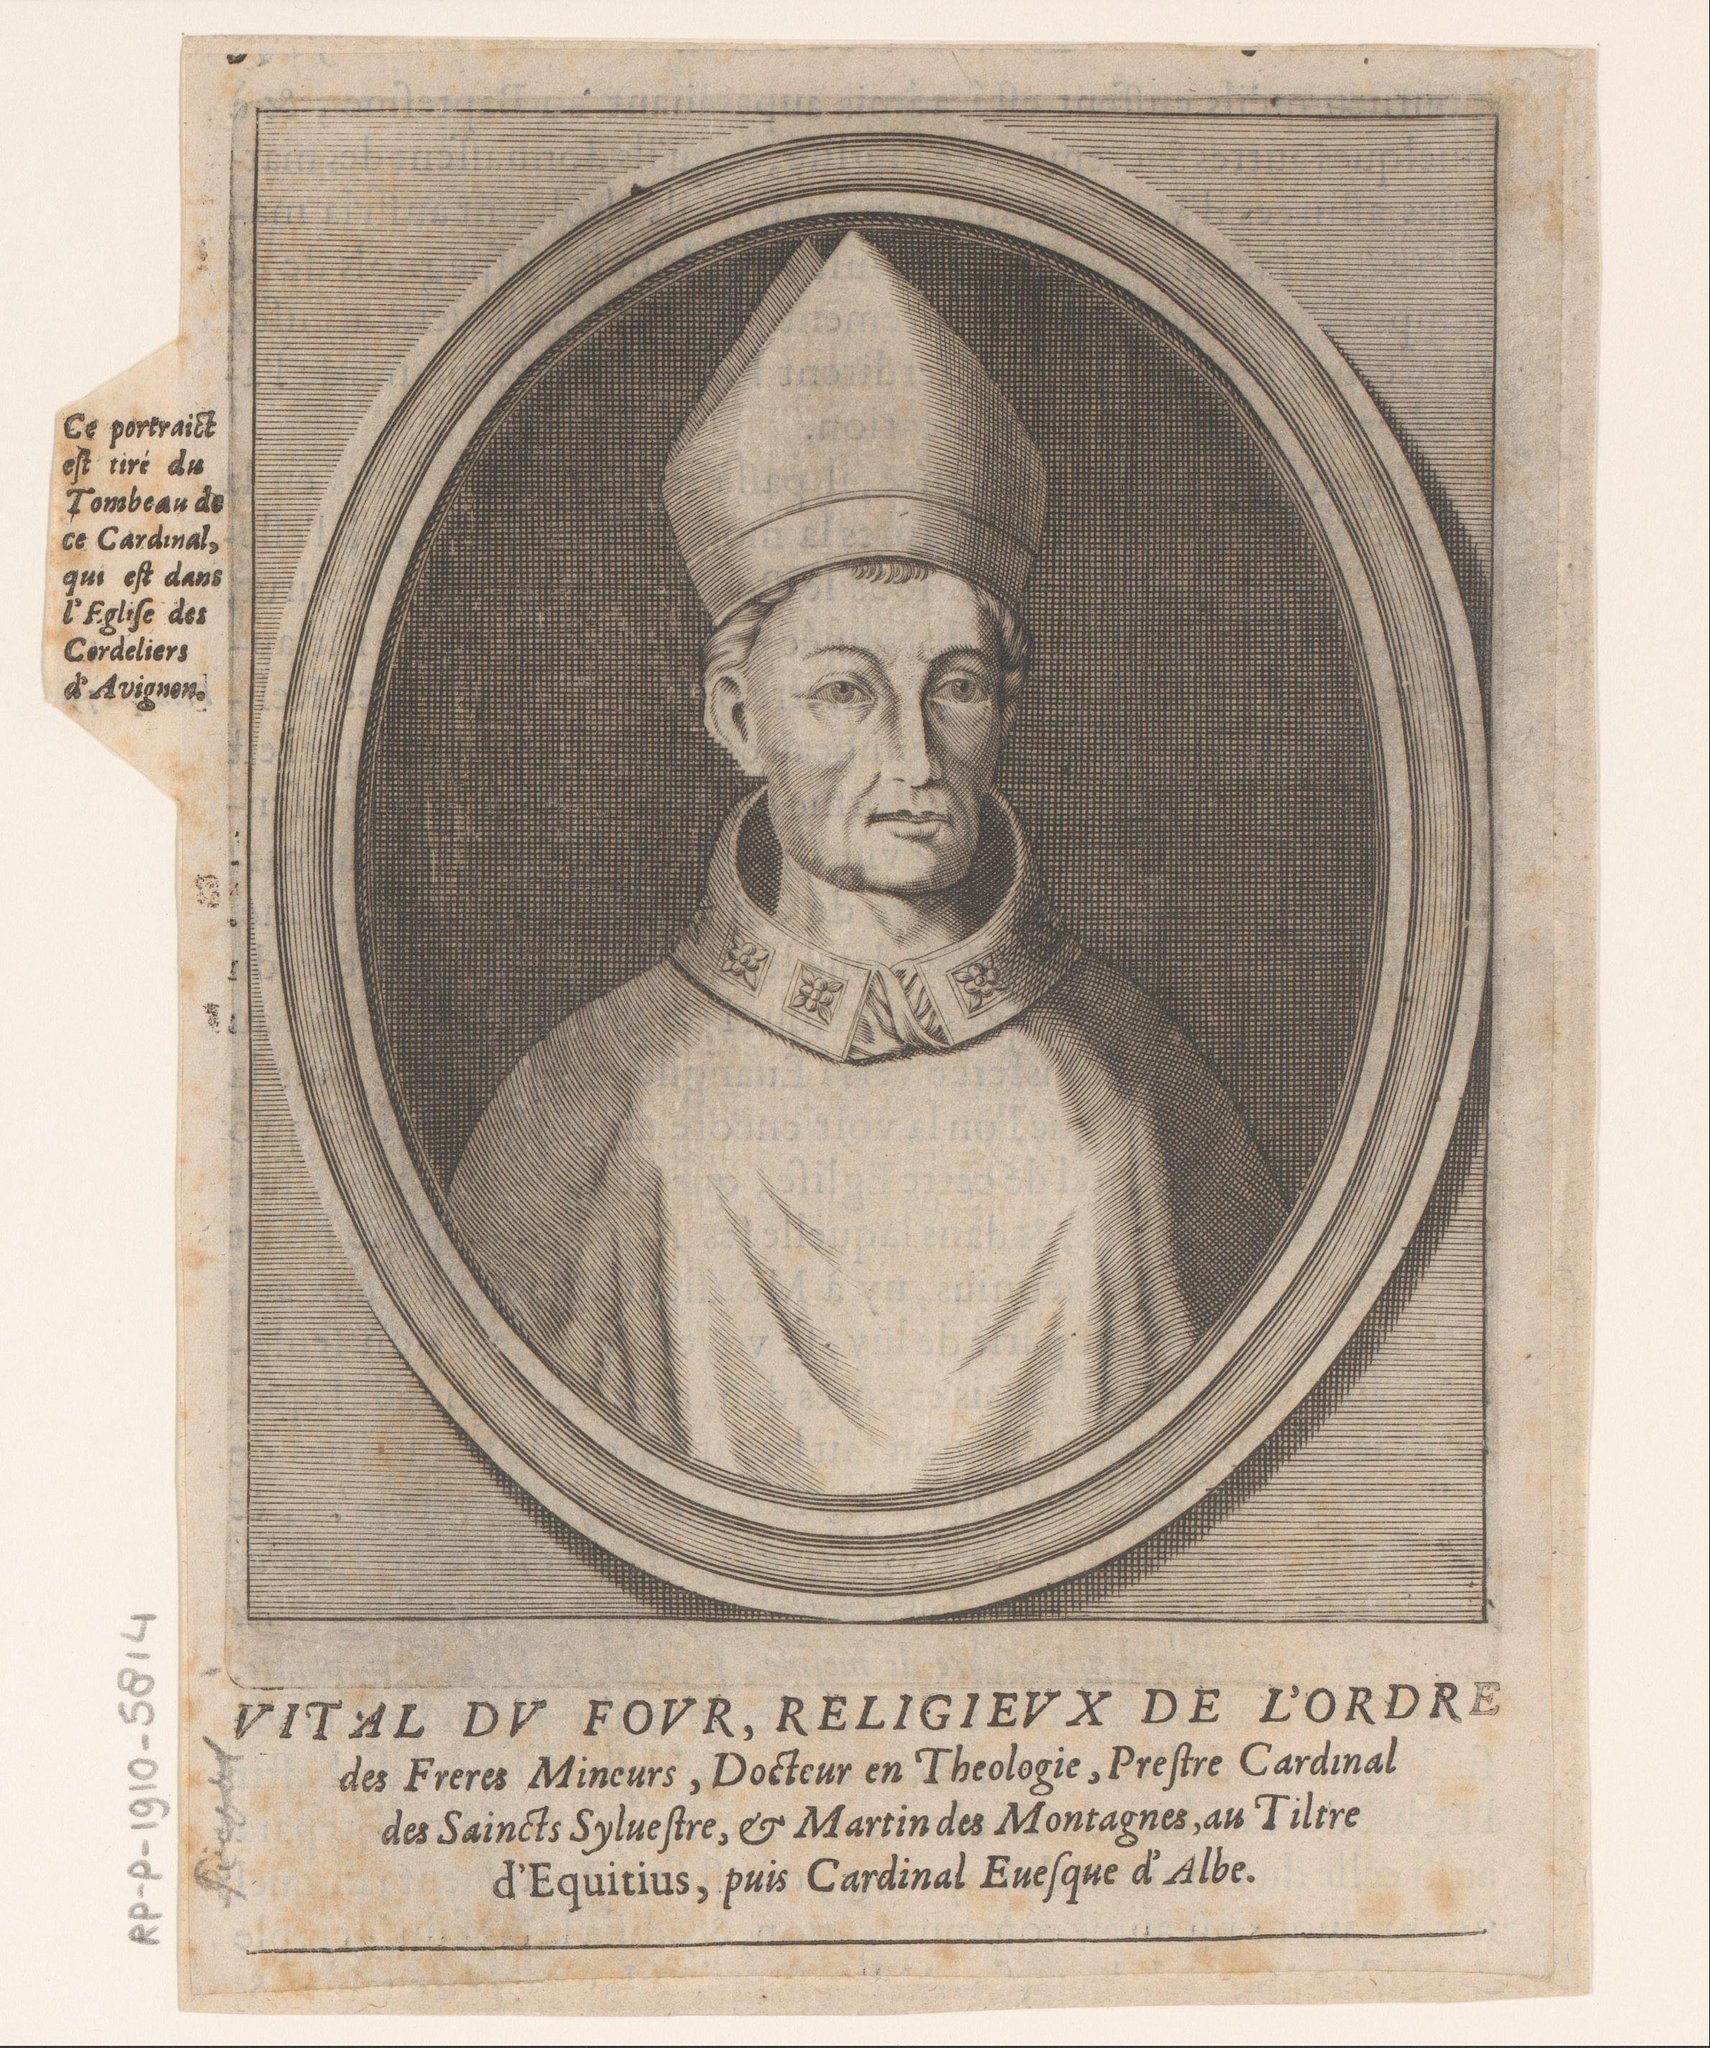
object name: book illustration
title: Portret van Vital du Four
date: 1660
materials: paper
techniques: engraving, etching, letterpress printing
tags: scholar, philosopher, cardinal, historical persons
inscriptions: collector's mark: Lugt 2228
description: Prent uit: Du Chesne, François. Histoire de tous les cardinaux françois de naissance, ou qui ont esté promeus au cardinalat. Parijs: François Du Chesne, 1660.